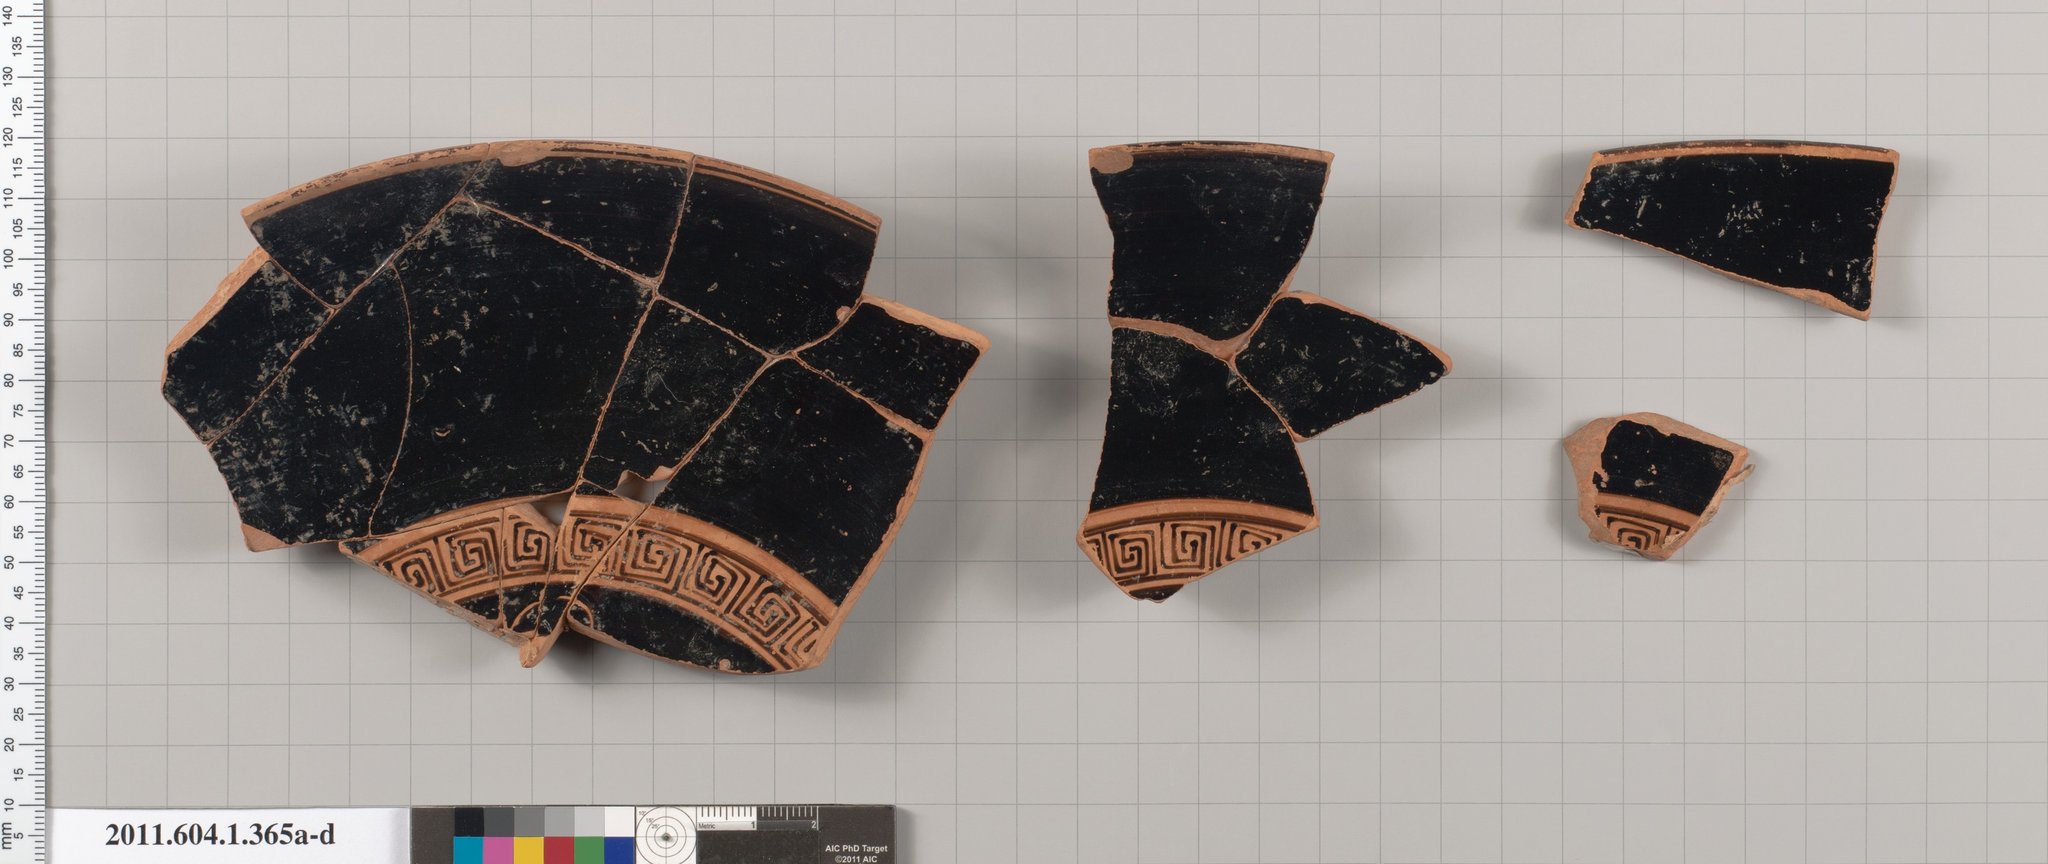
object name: kylix fragment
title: Terracotta fragments of a kylix (drinking cup)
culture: greek, attic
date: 467-435 BCE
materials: terracotta